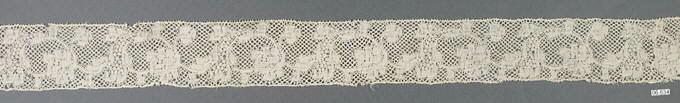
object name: strip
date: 1701-1800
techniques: lace